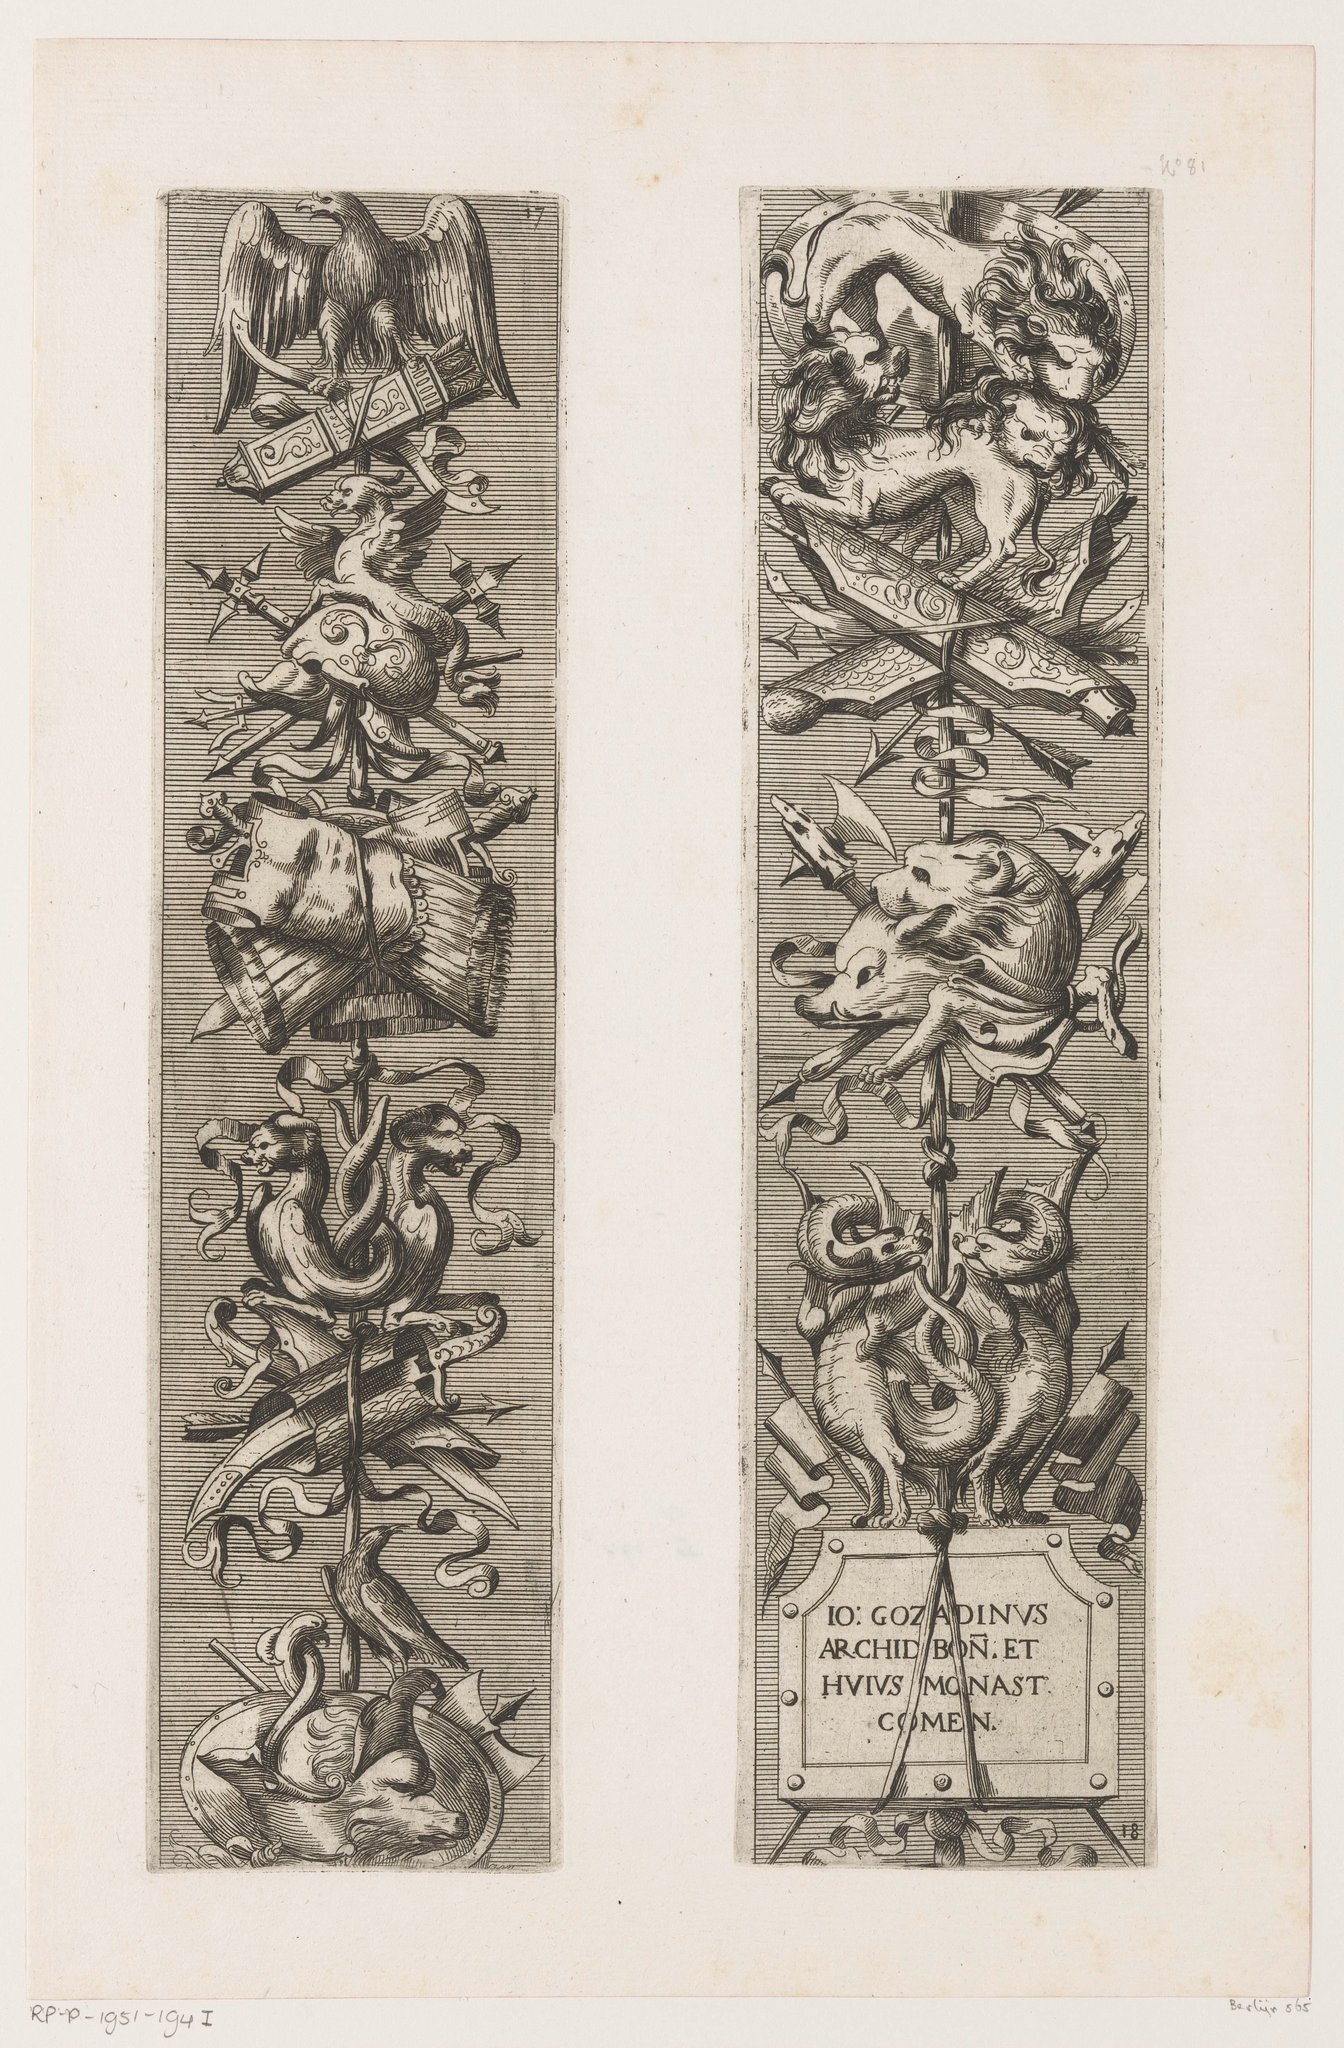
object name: print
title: Twee kandelabers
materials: paper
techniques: etching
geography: rome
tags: ornament ~ candelabrum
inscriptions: collector's mark: Lugt 2228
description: Deze prent maakt deel uit van een reeks van 48 prenten plus een titelprent. Mitelli maakte tekeningen van marmeren pilasterdecoraties van de poort van de S. Bartolomeo di Porta Ravegnana in Bologna. Deze prenten zijn vervolgens naar die tekeningen gemaakt.